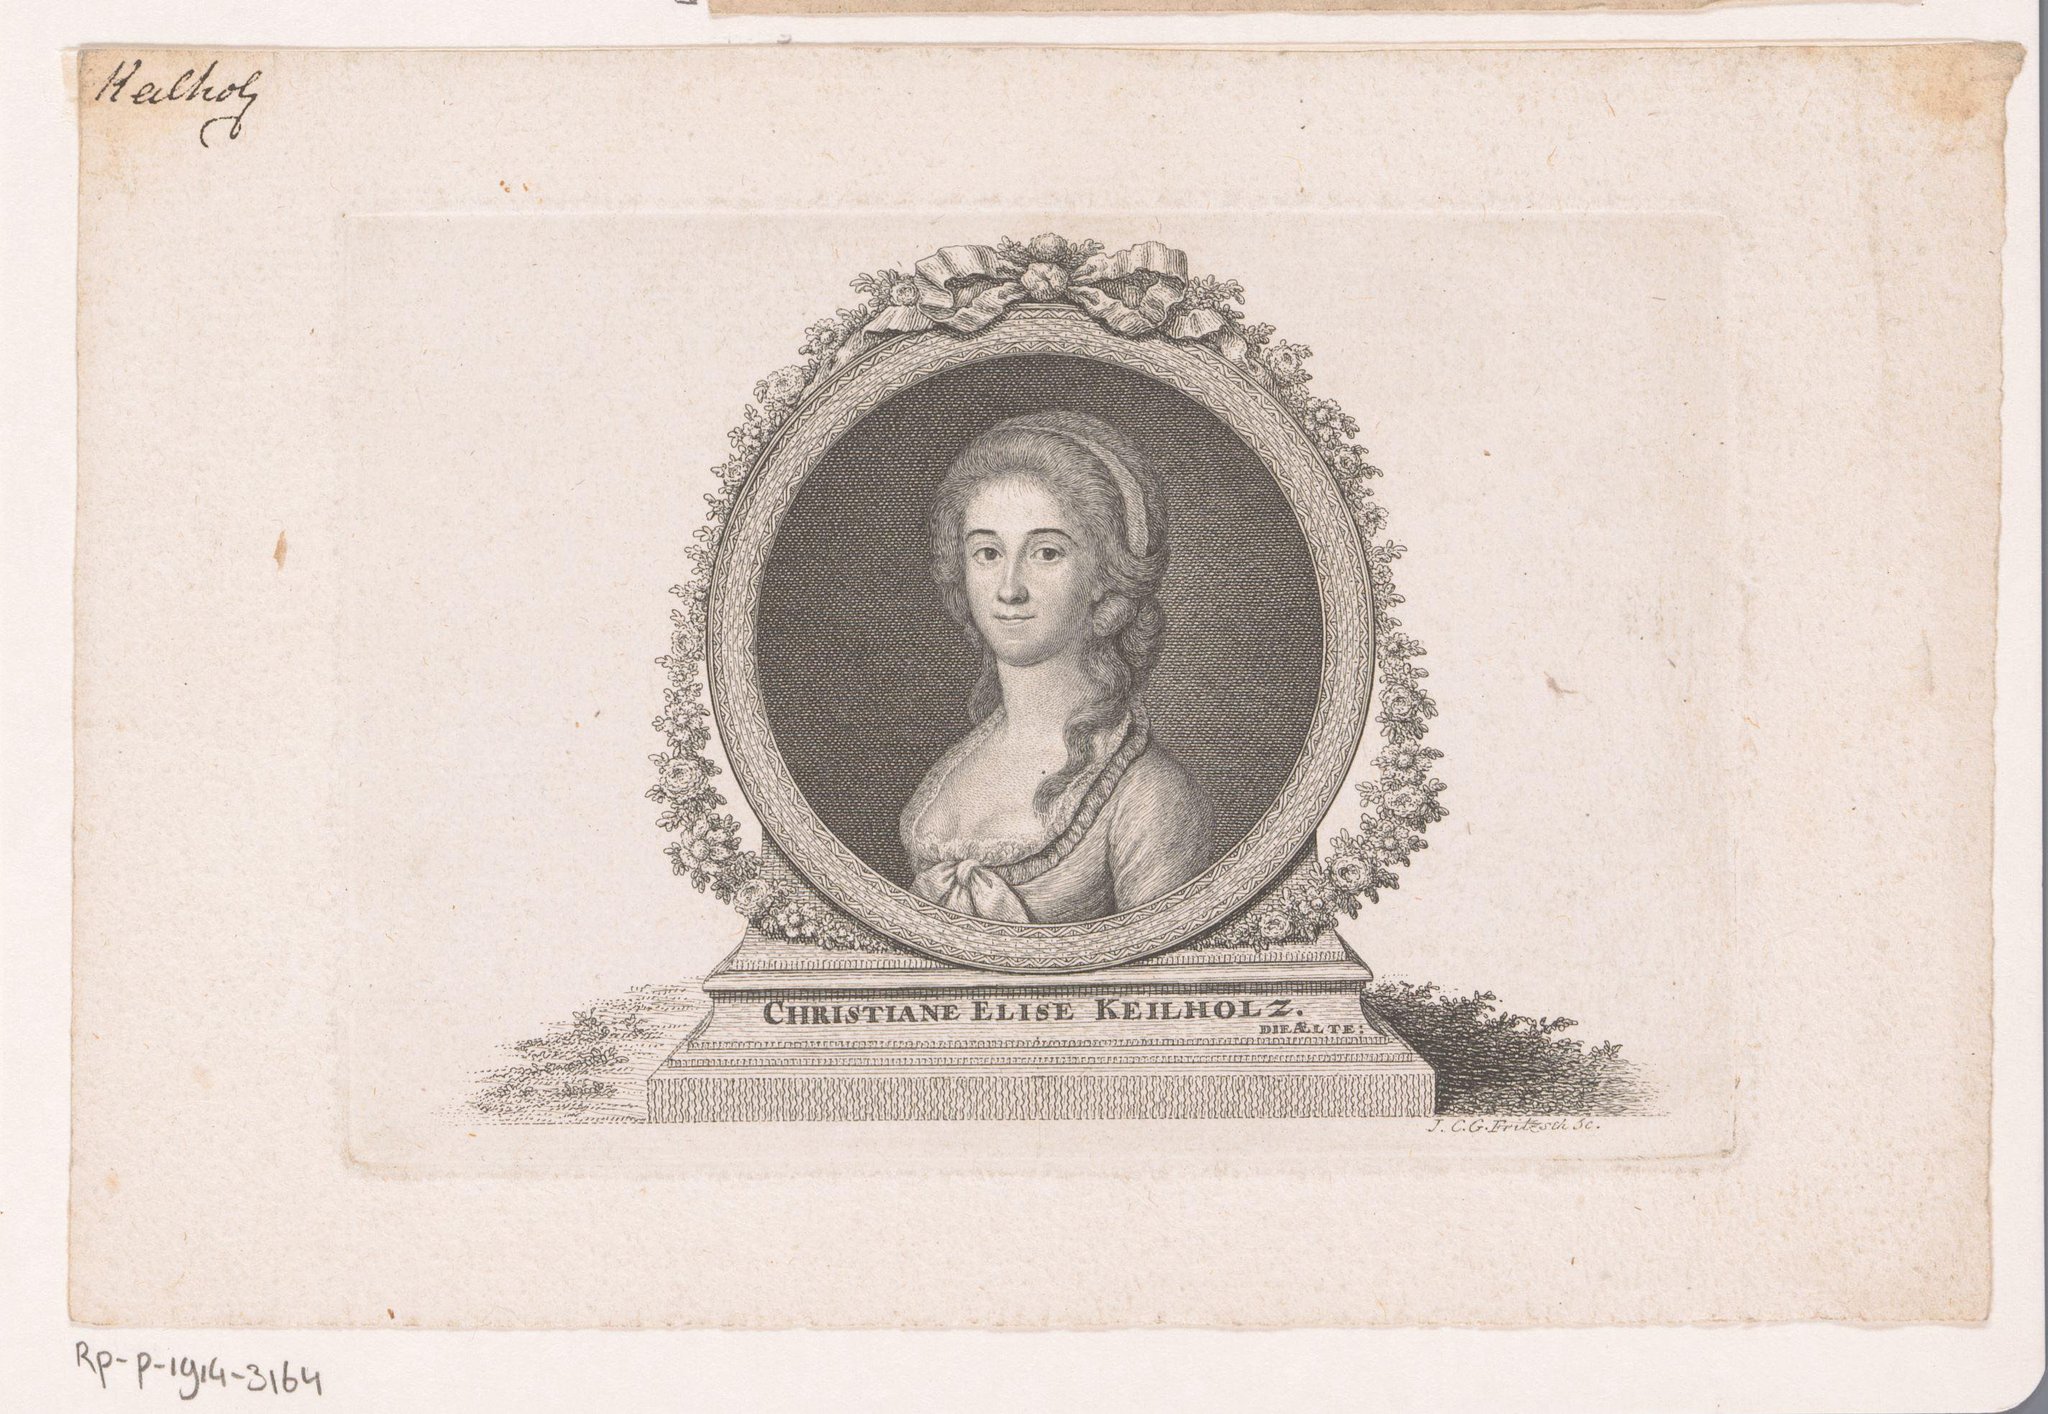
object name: print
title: Portret van Christiane Magdalena Elisabeth Keilholz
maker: johann christian gottfried fritzsch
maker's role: print maker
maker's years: 1720-1802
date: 1774-1802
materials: paper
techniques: engraving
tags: ornament ~ medallion, historical persons, ornament ~ festoon, garland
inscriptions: collector's mark: Lugt 2228